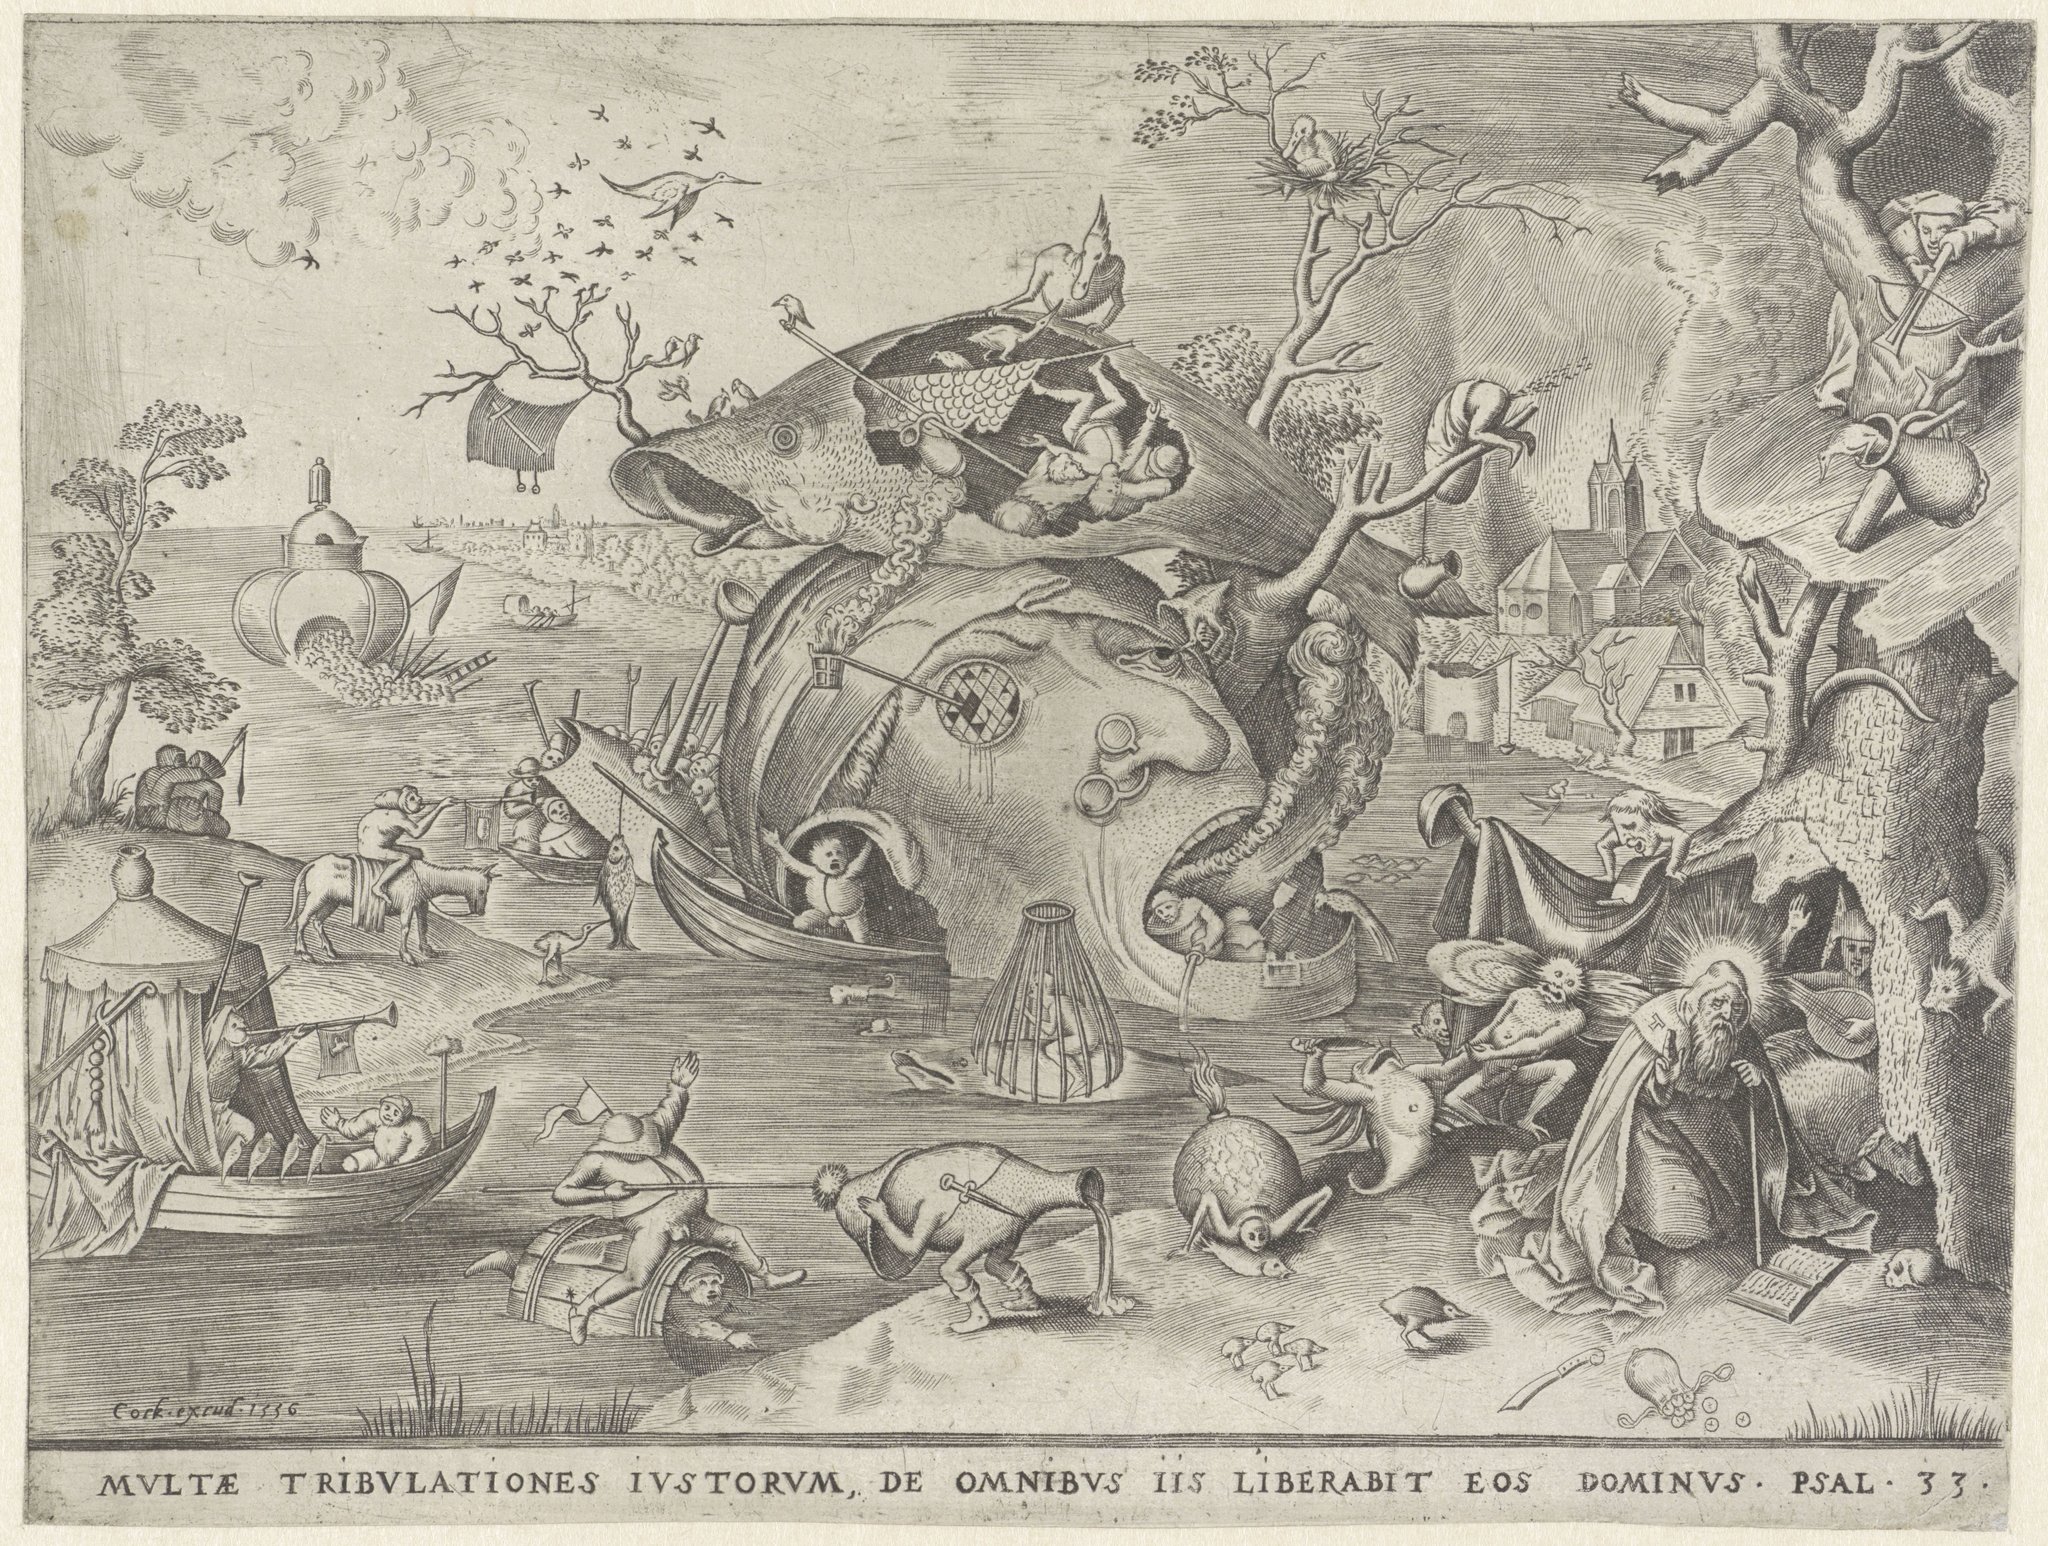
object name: print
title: Verzoeking van de H. Antonius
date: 1556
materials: paper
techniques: engraving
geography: antwerp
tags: st. antony abbot tormented by devils, attacking him on the ground or carrying him aloft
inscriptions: collector's mark: Lugt 2228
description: De heilige Antonius zit geknield bij een holle boom en bidt, terwijl hij door duivels en demonen wordt verzocht en belaagd. Onder de voorstelling een verwijzing in het Latijn naar Psalm 33.